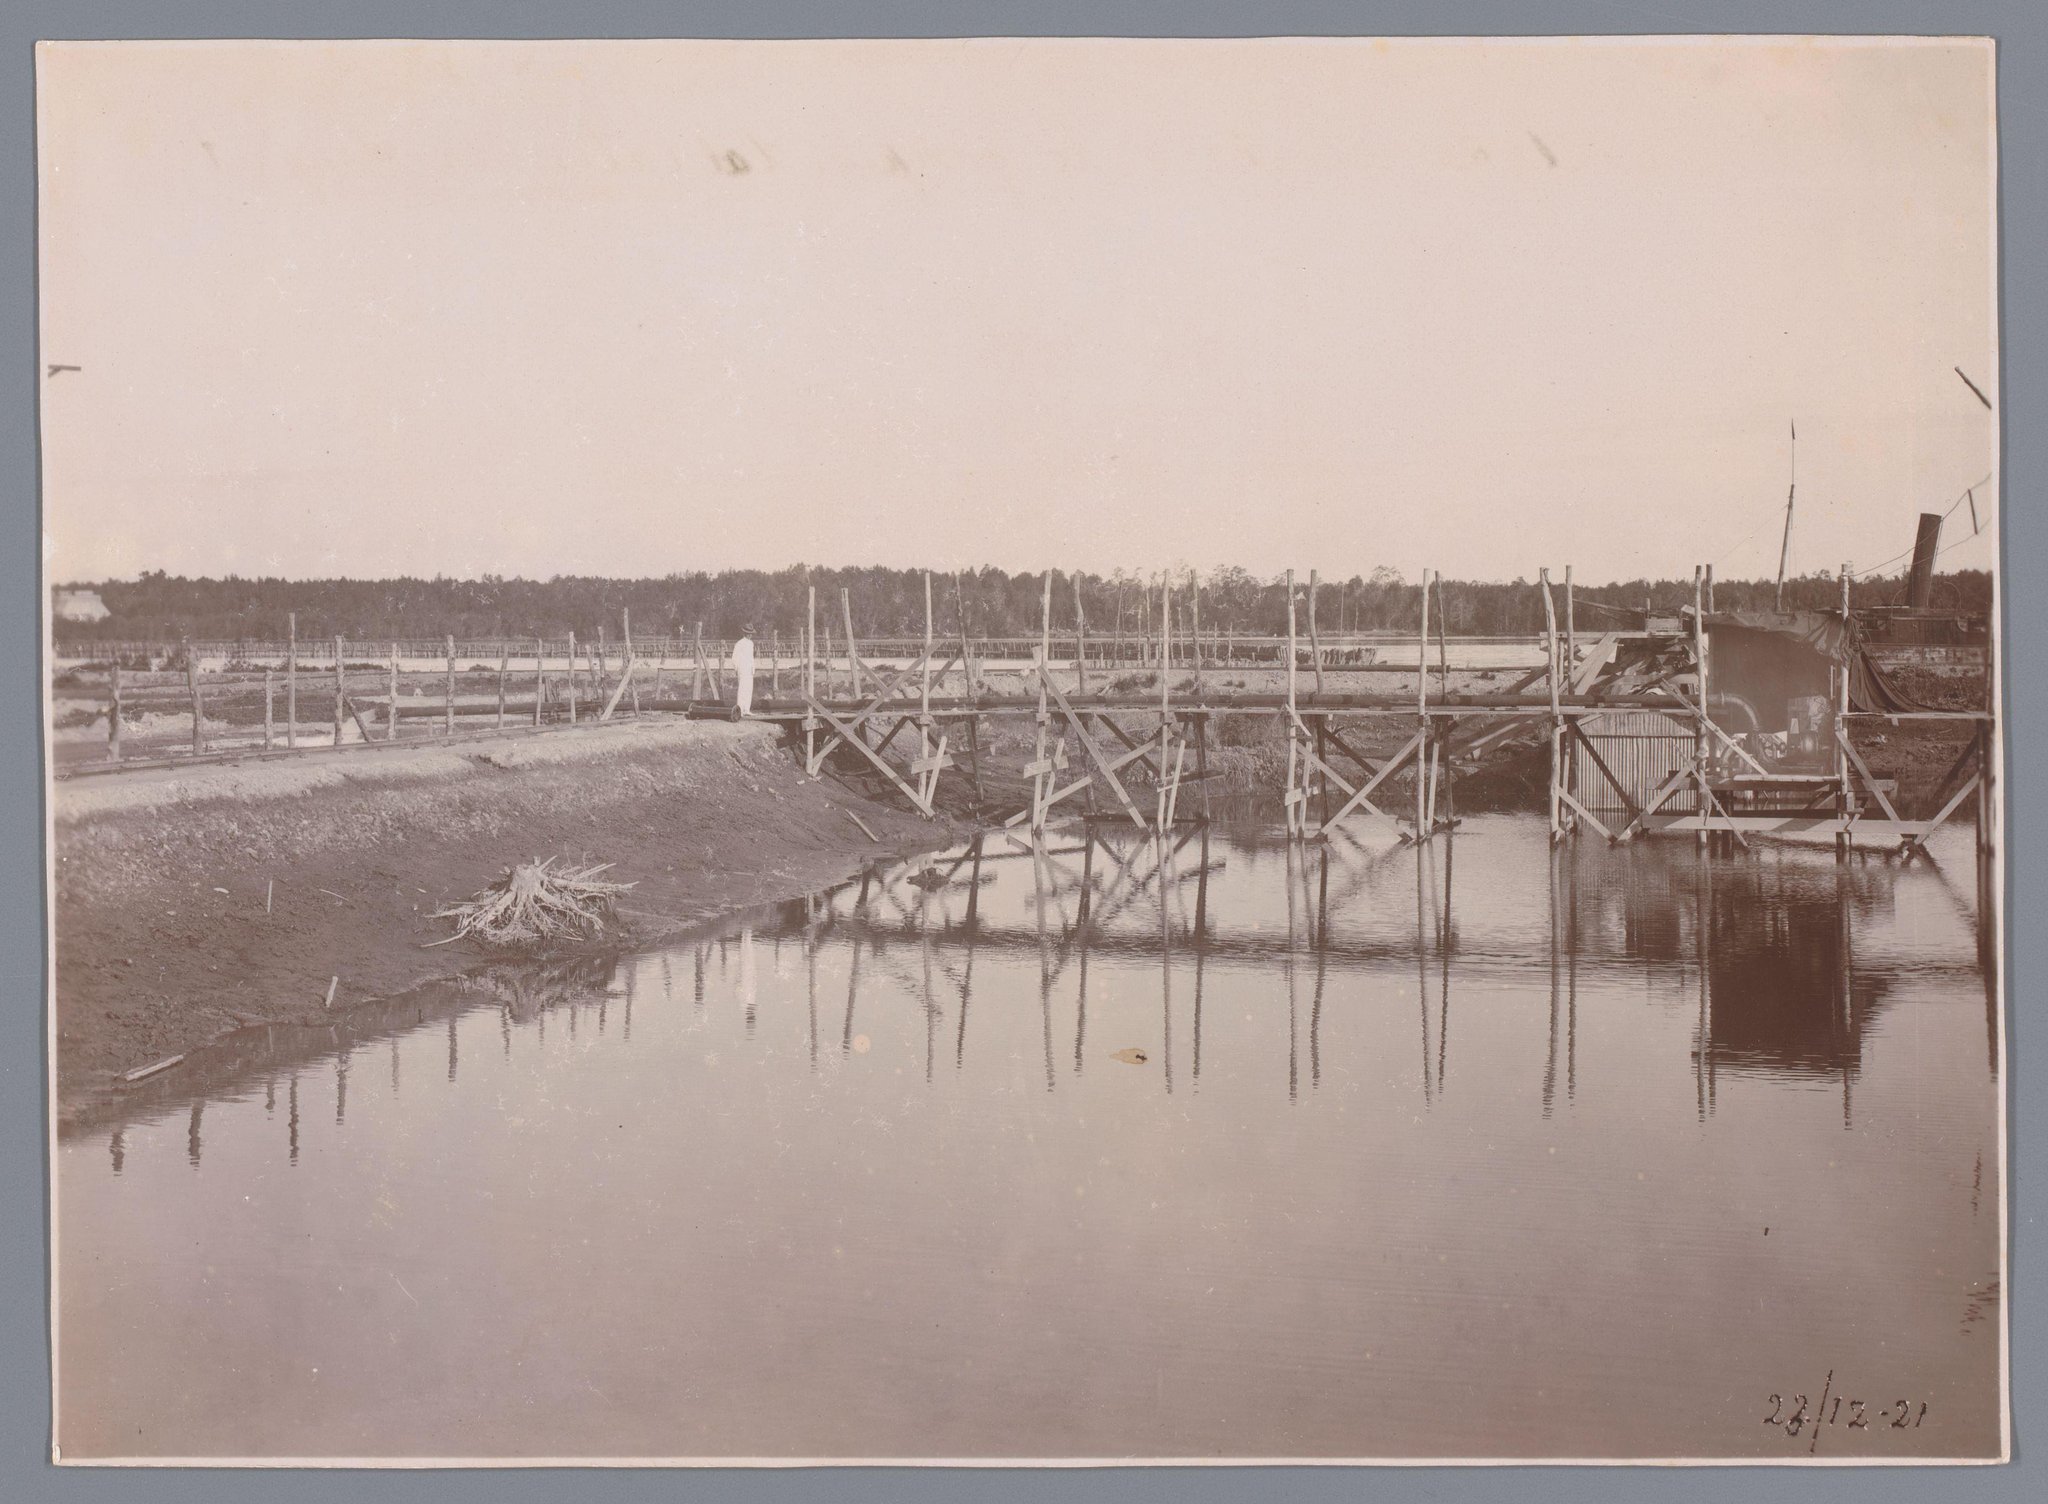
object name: photograph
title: Oceaanhaven Belawan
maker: Anonymous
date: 1921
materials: photographic support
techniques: gelatin silver print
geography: belawan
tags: harbour, pump, building-site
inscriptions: inscription: ‘No 104 Tijdelijke electrische pompinstallatie in den put’, date: ‘23/12-21’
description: Steiger met pompinstallatie in de bouwput. Genummerd: 104. Onderdeel van de groep van losse foto's over de aanleg van de haven Belawan aan de kust voor Medan, Sumatra 1921-1922.